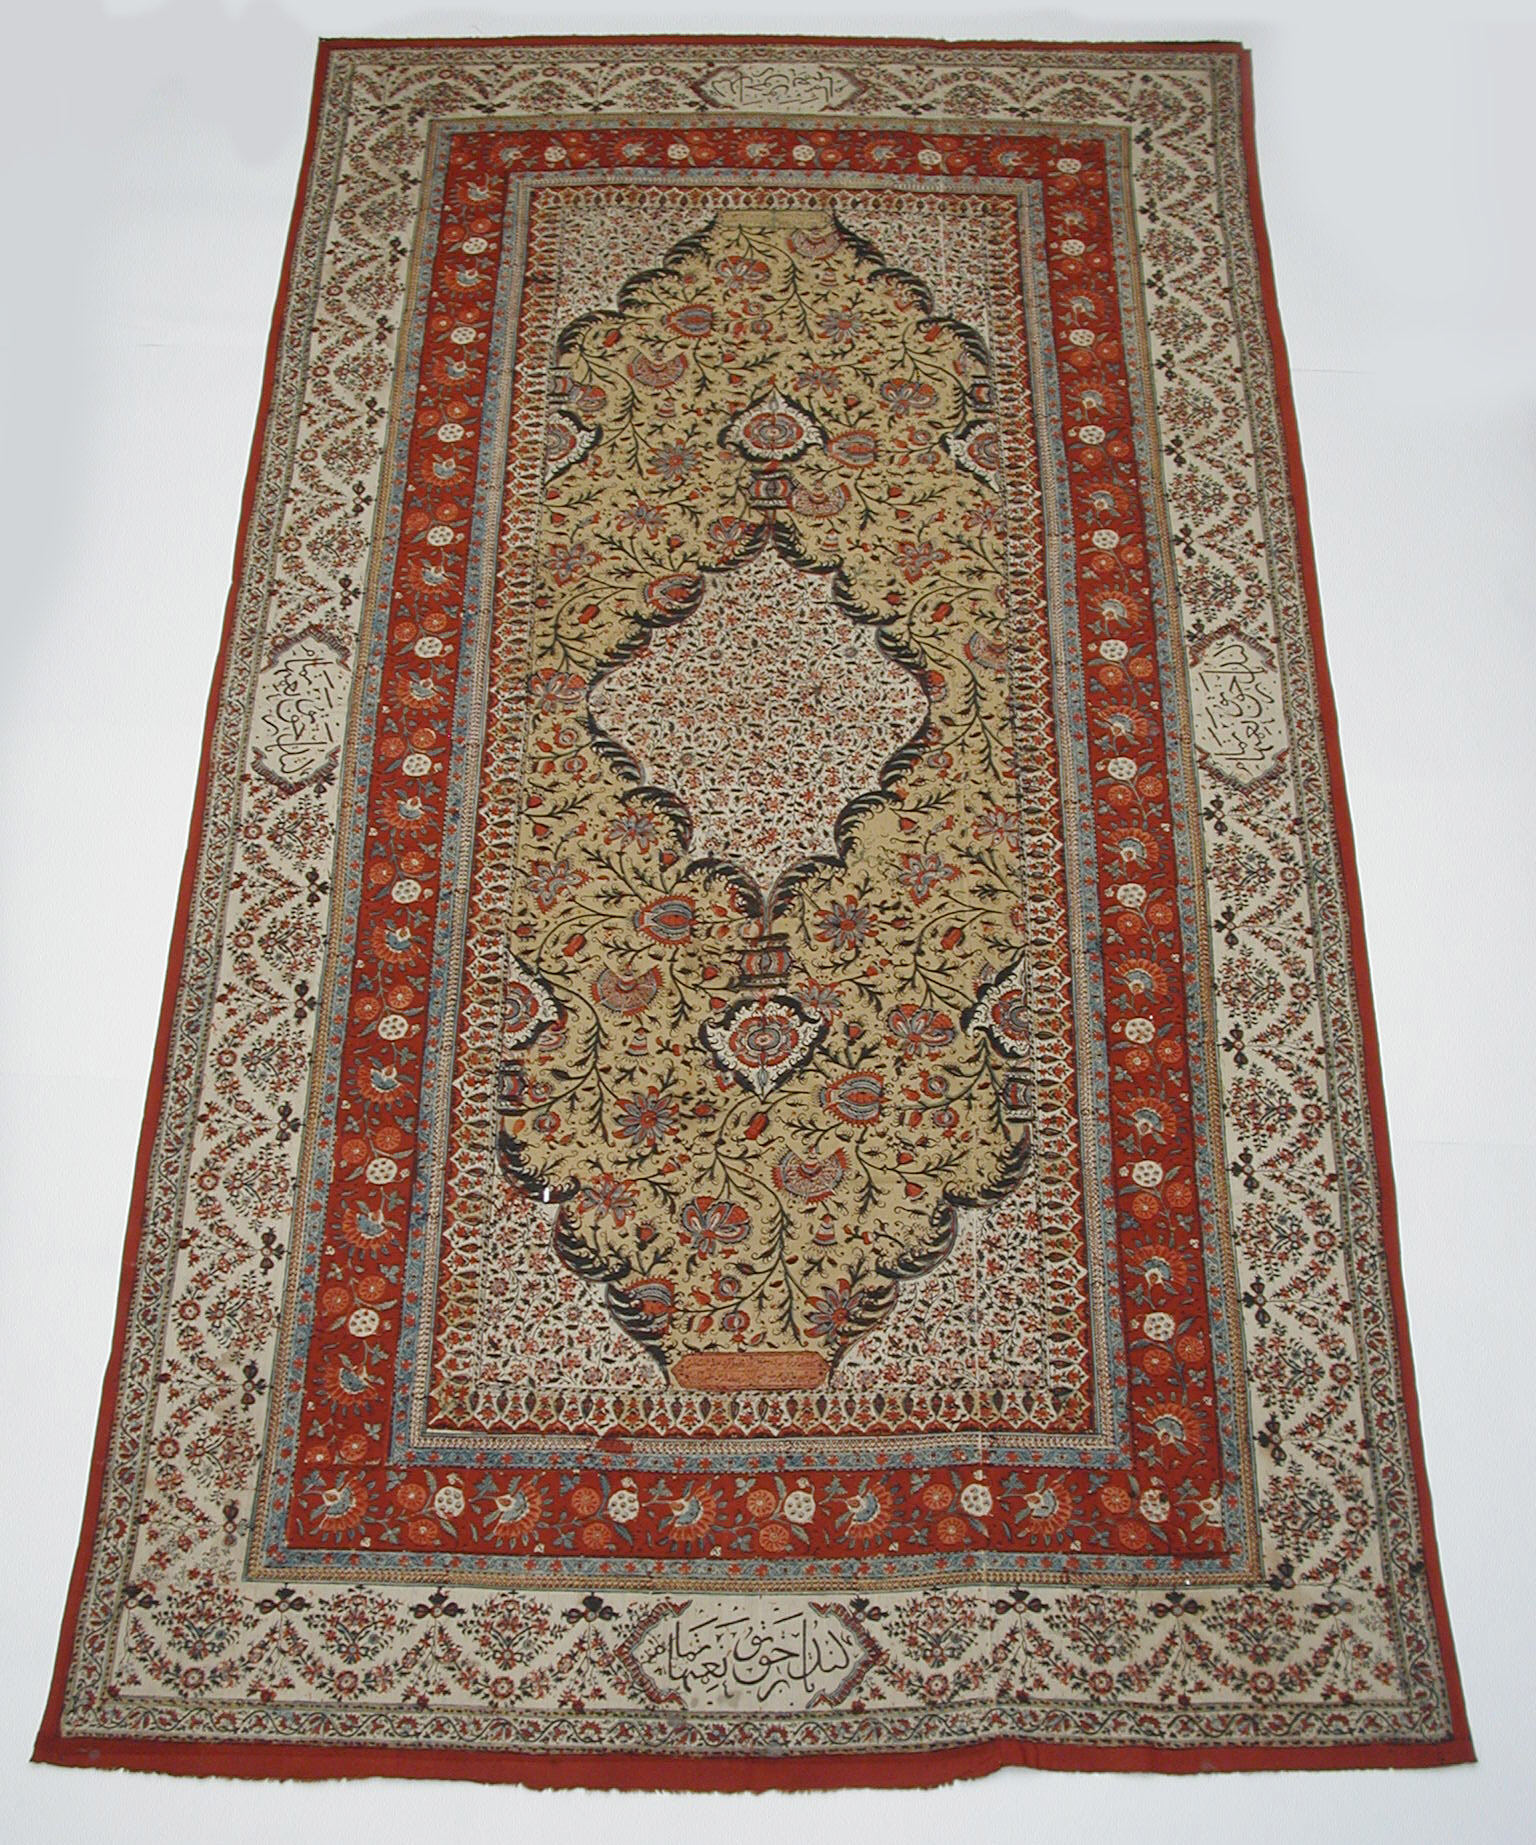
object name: cover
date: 1801-1900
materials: cotton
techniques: weave, printing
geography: iran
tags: flowers